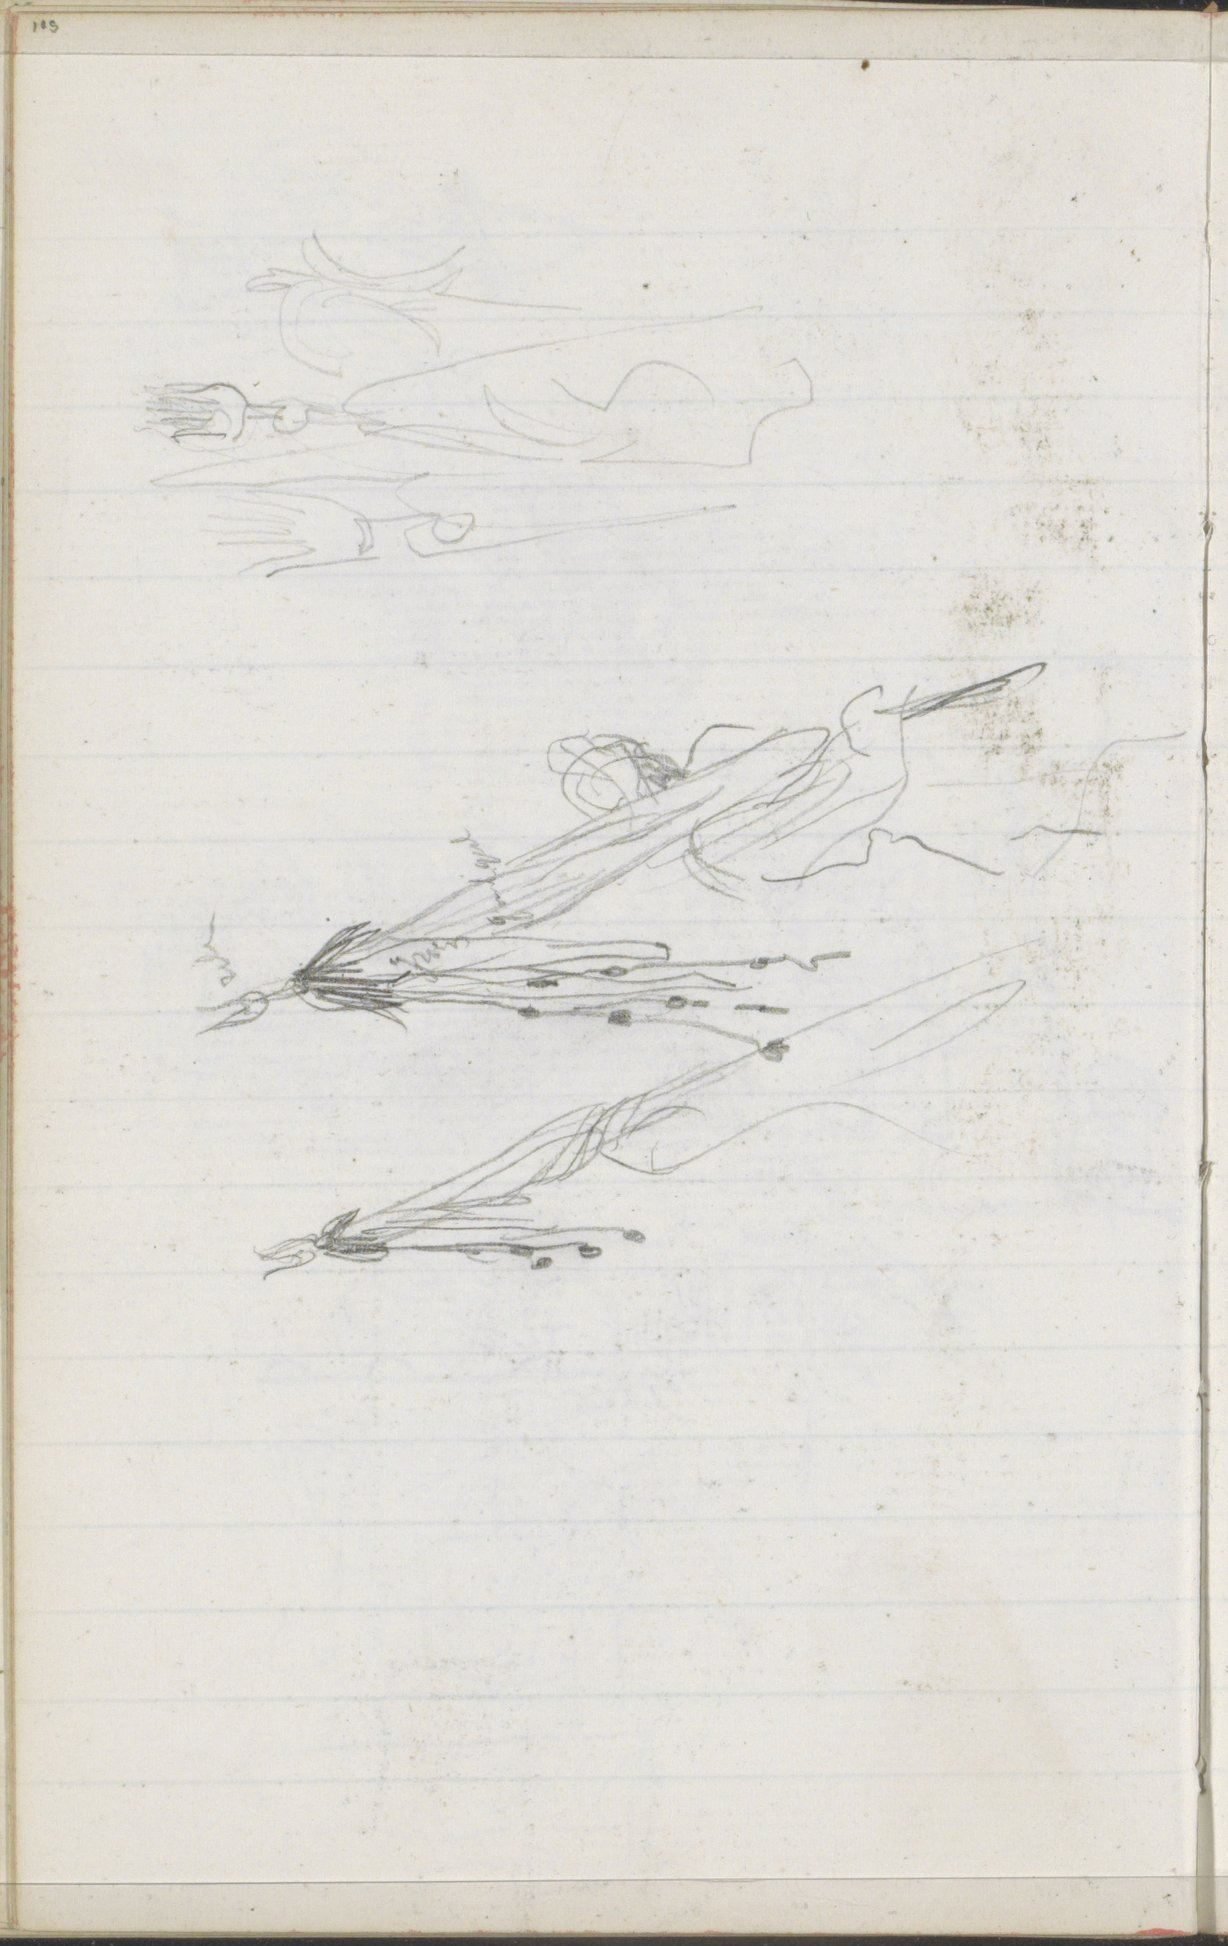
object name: sketchbook leaf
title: Indiase vaandeldrager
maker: marius bauer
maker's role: draughtsman, print maker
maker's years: 1867-1932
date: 1897-1898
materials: pencil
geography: india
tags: standard-bearer, flag-bearer, flags (~ signalling), asiatic races and peoples: indians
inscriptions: kleurnotitie, handgeschreven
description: Pagina 105 uit een schetsboek met 62 bladen.